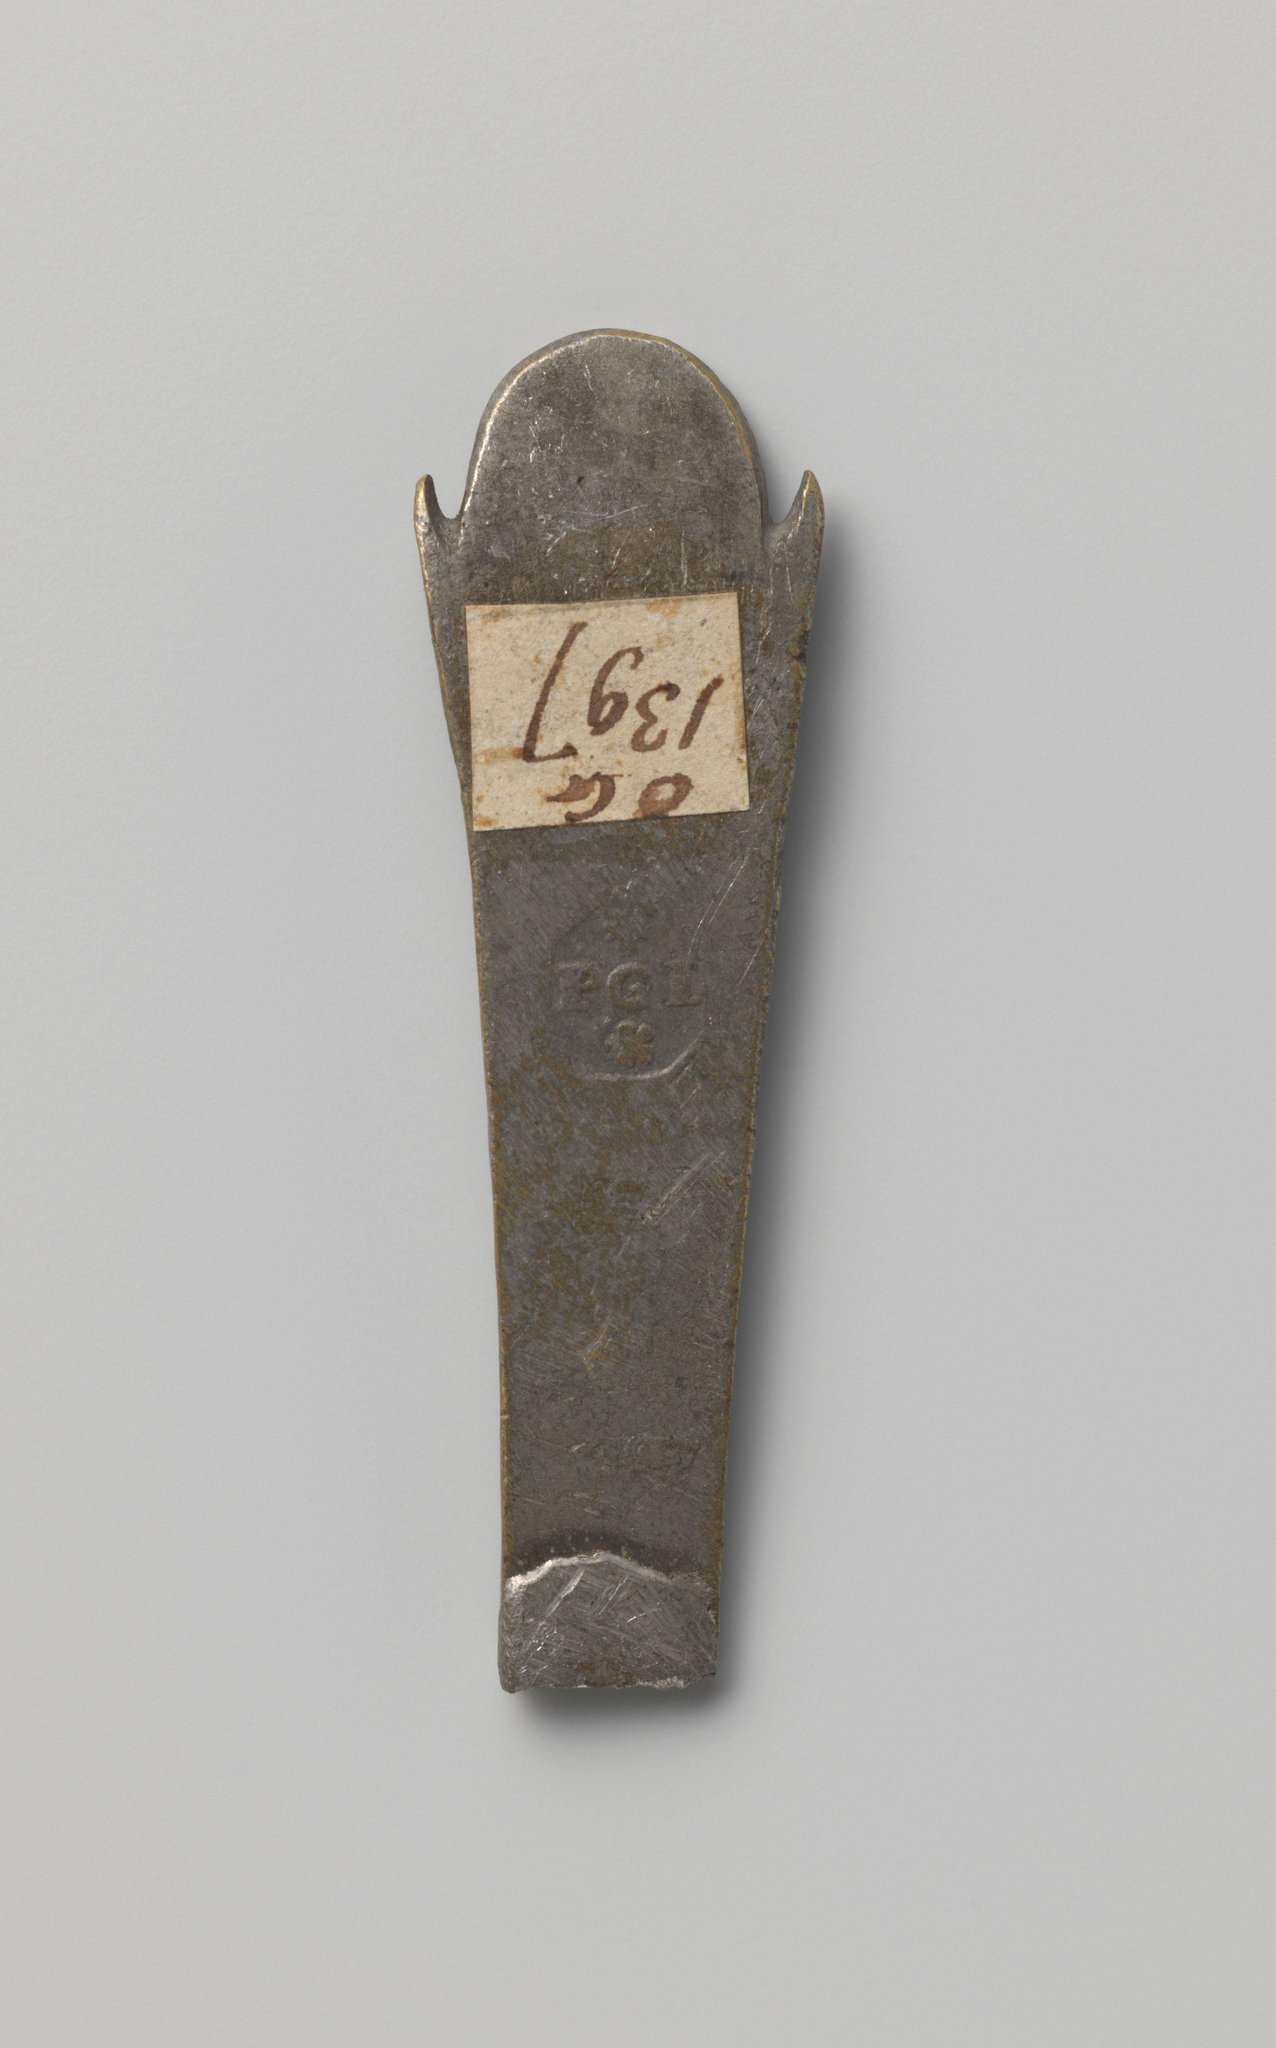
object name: flatware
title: Fragment van een bestekhandvat van messing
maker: Anonymous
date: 1600-1800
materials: brass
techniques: casting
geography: western europe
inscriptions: inscription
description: Fragment van messing. Het gaat om het uiteinde van een bestekhandvat (lepel of vork). Het handvat sluit met een halfronde vorm met twee puntige uitstulpingen aan weerszijden.